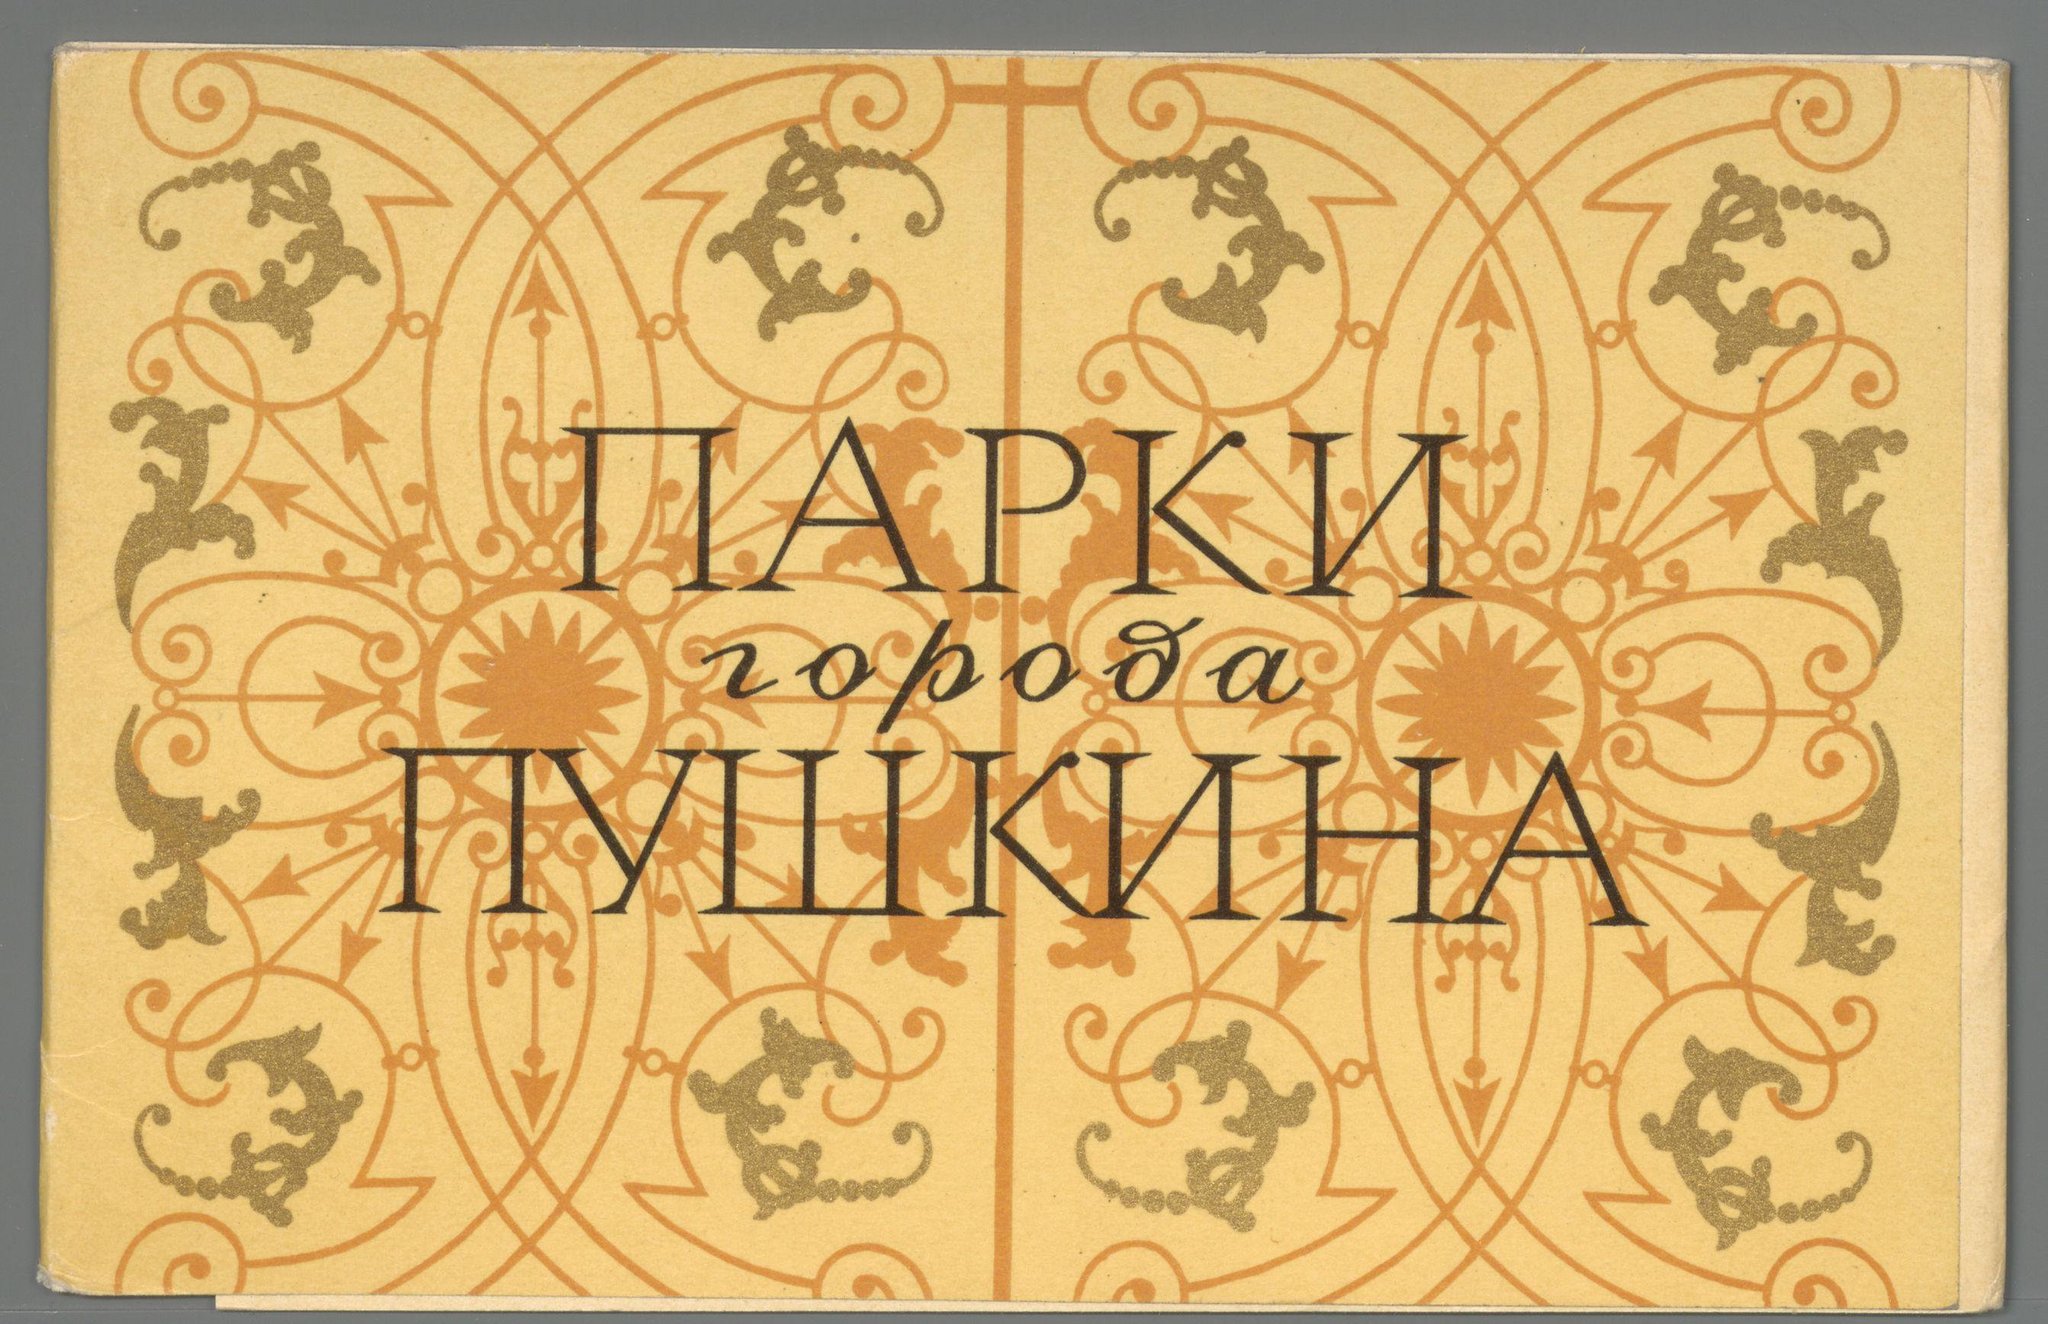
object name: reproduction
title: Omslag voor twaalf prentbriefkaarten met gezichten van parken in Poesjkin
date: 1967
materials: cardboard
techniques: lithograph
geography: moscow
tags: poesjkin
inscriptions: date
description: De titel op object staat in het Russisch.